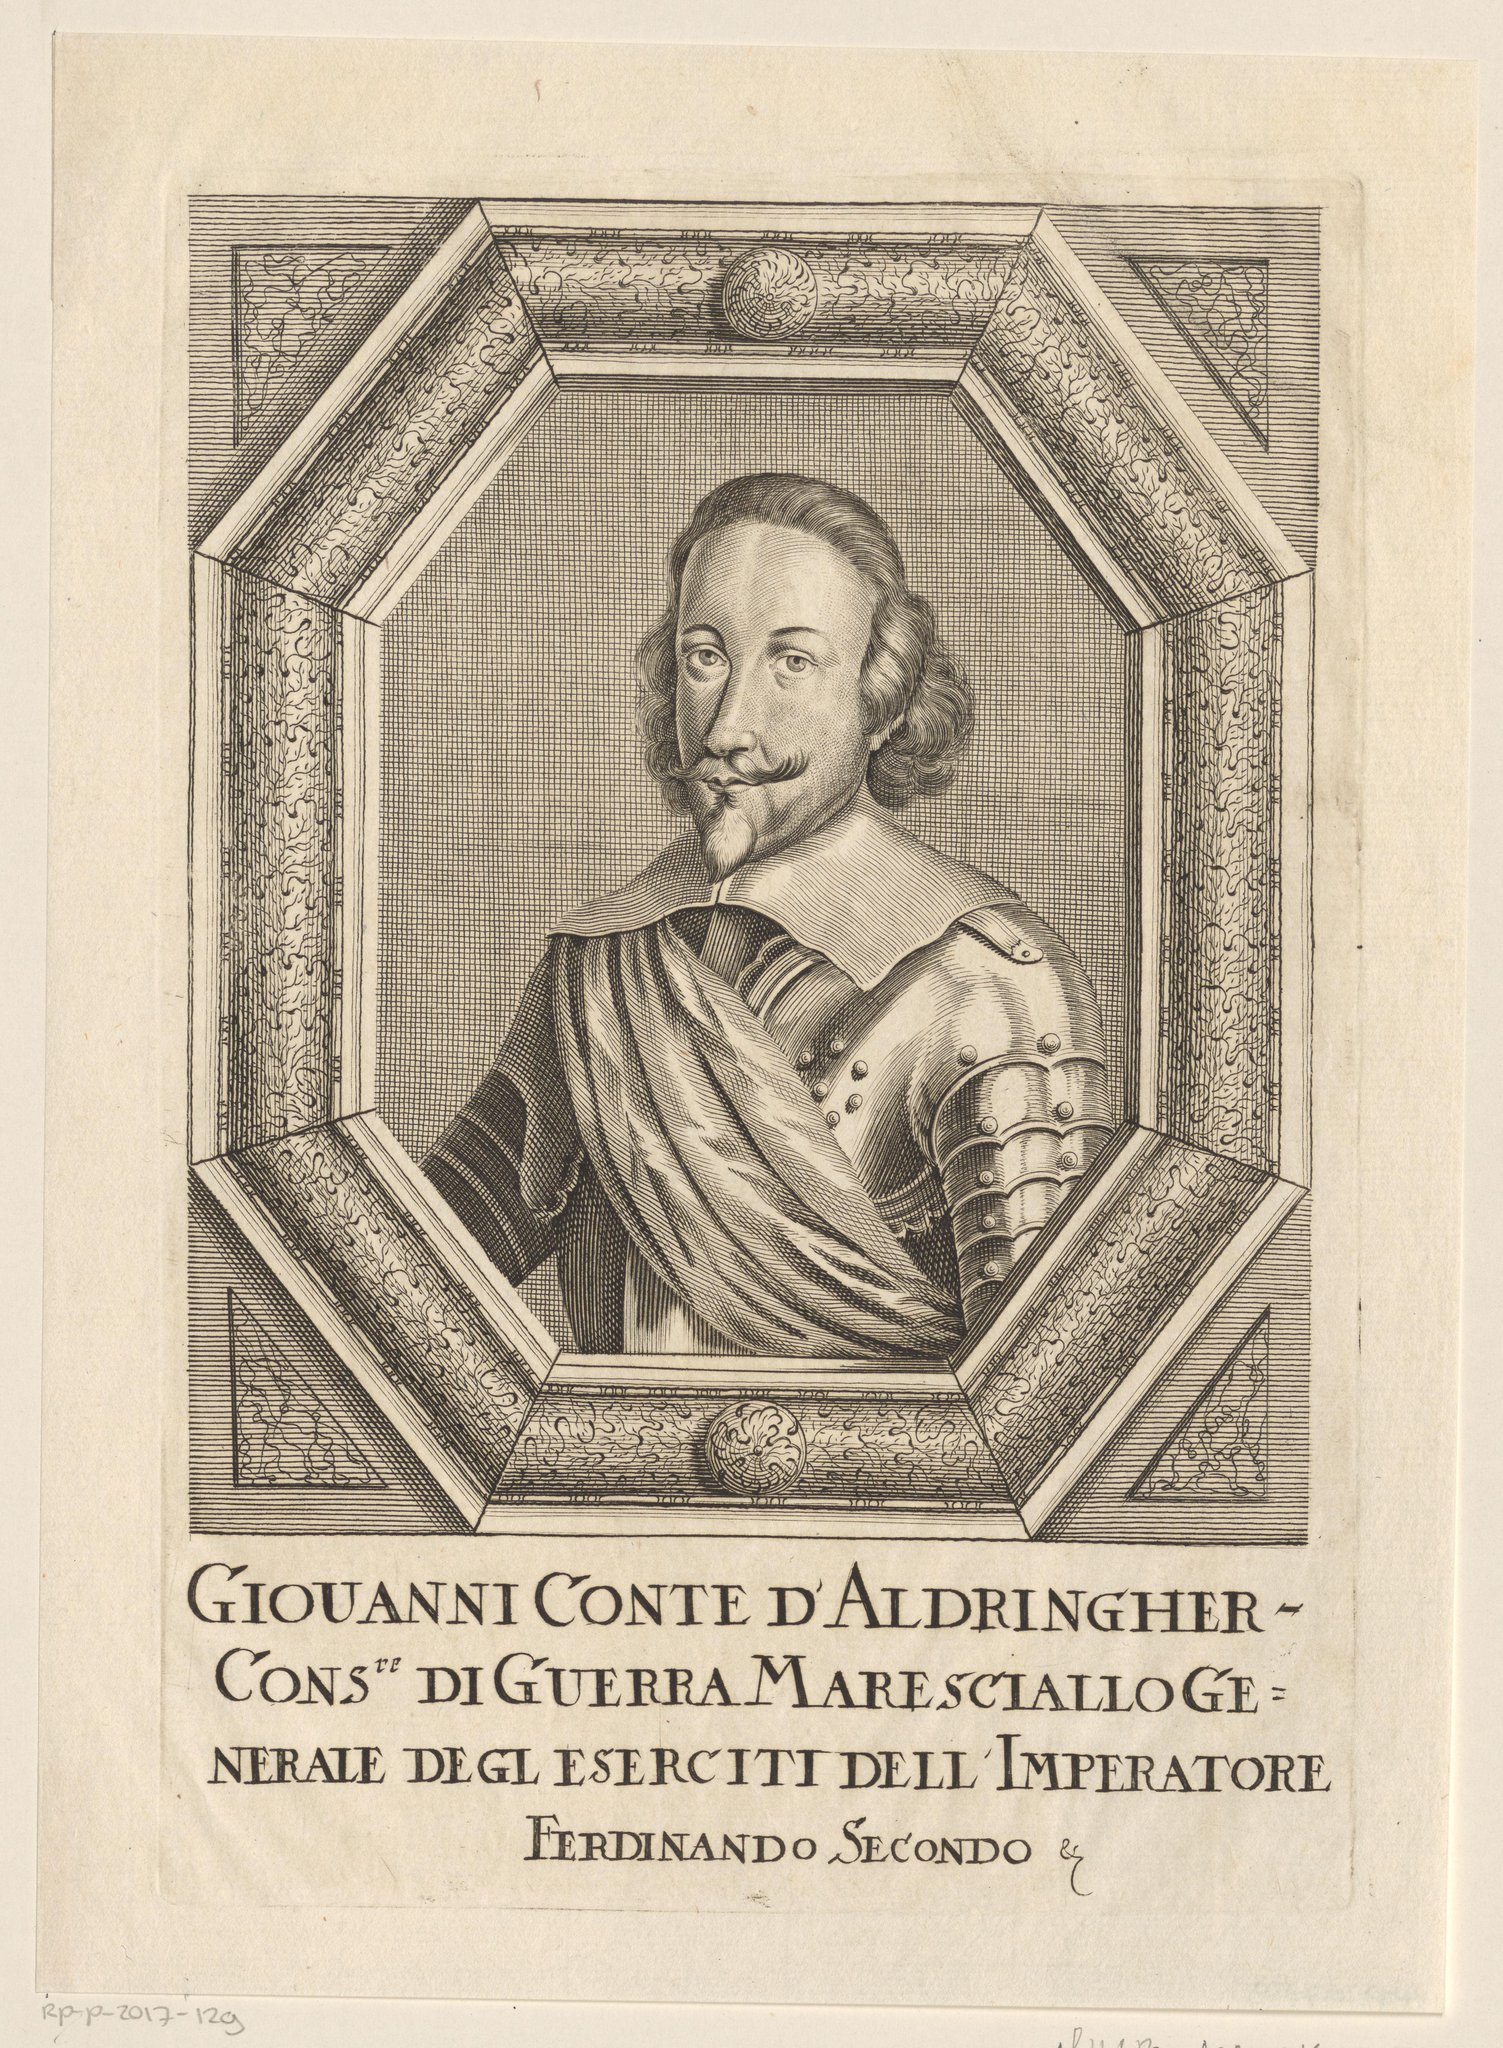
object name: print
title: Portret van Johann, graaf van Aldringen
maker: Anonymous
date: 1650-1749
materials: paper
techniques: engraving, etching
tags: thionville, bevelhebber, johann rijksgraaf van aldringen